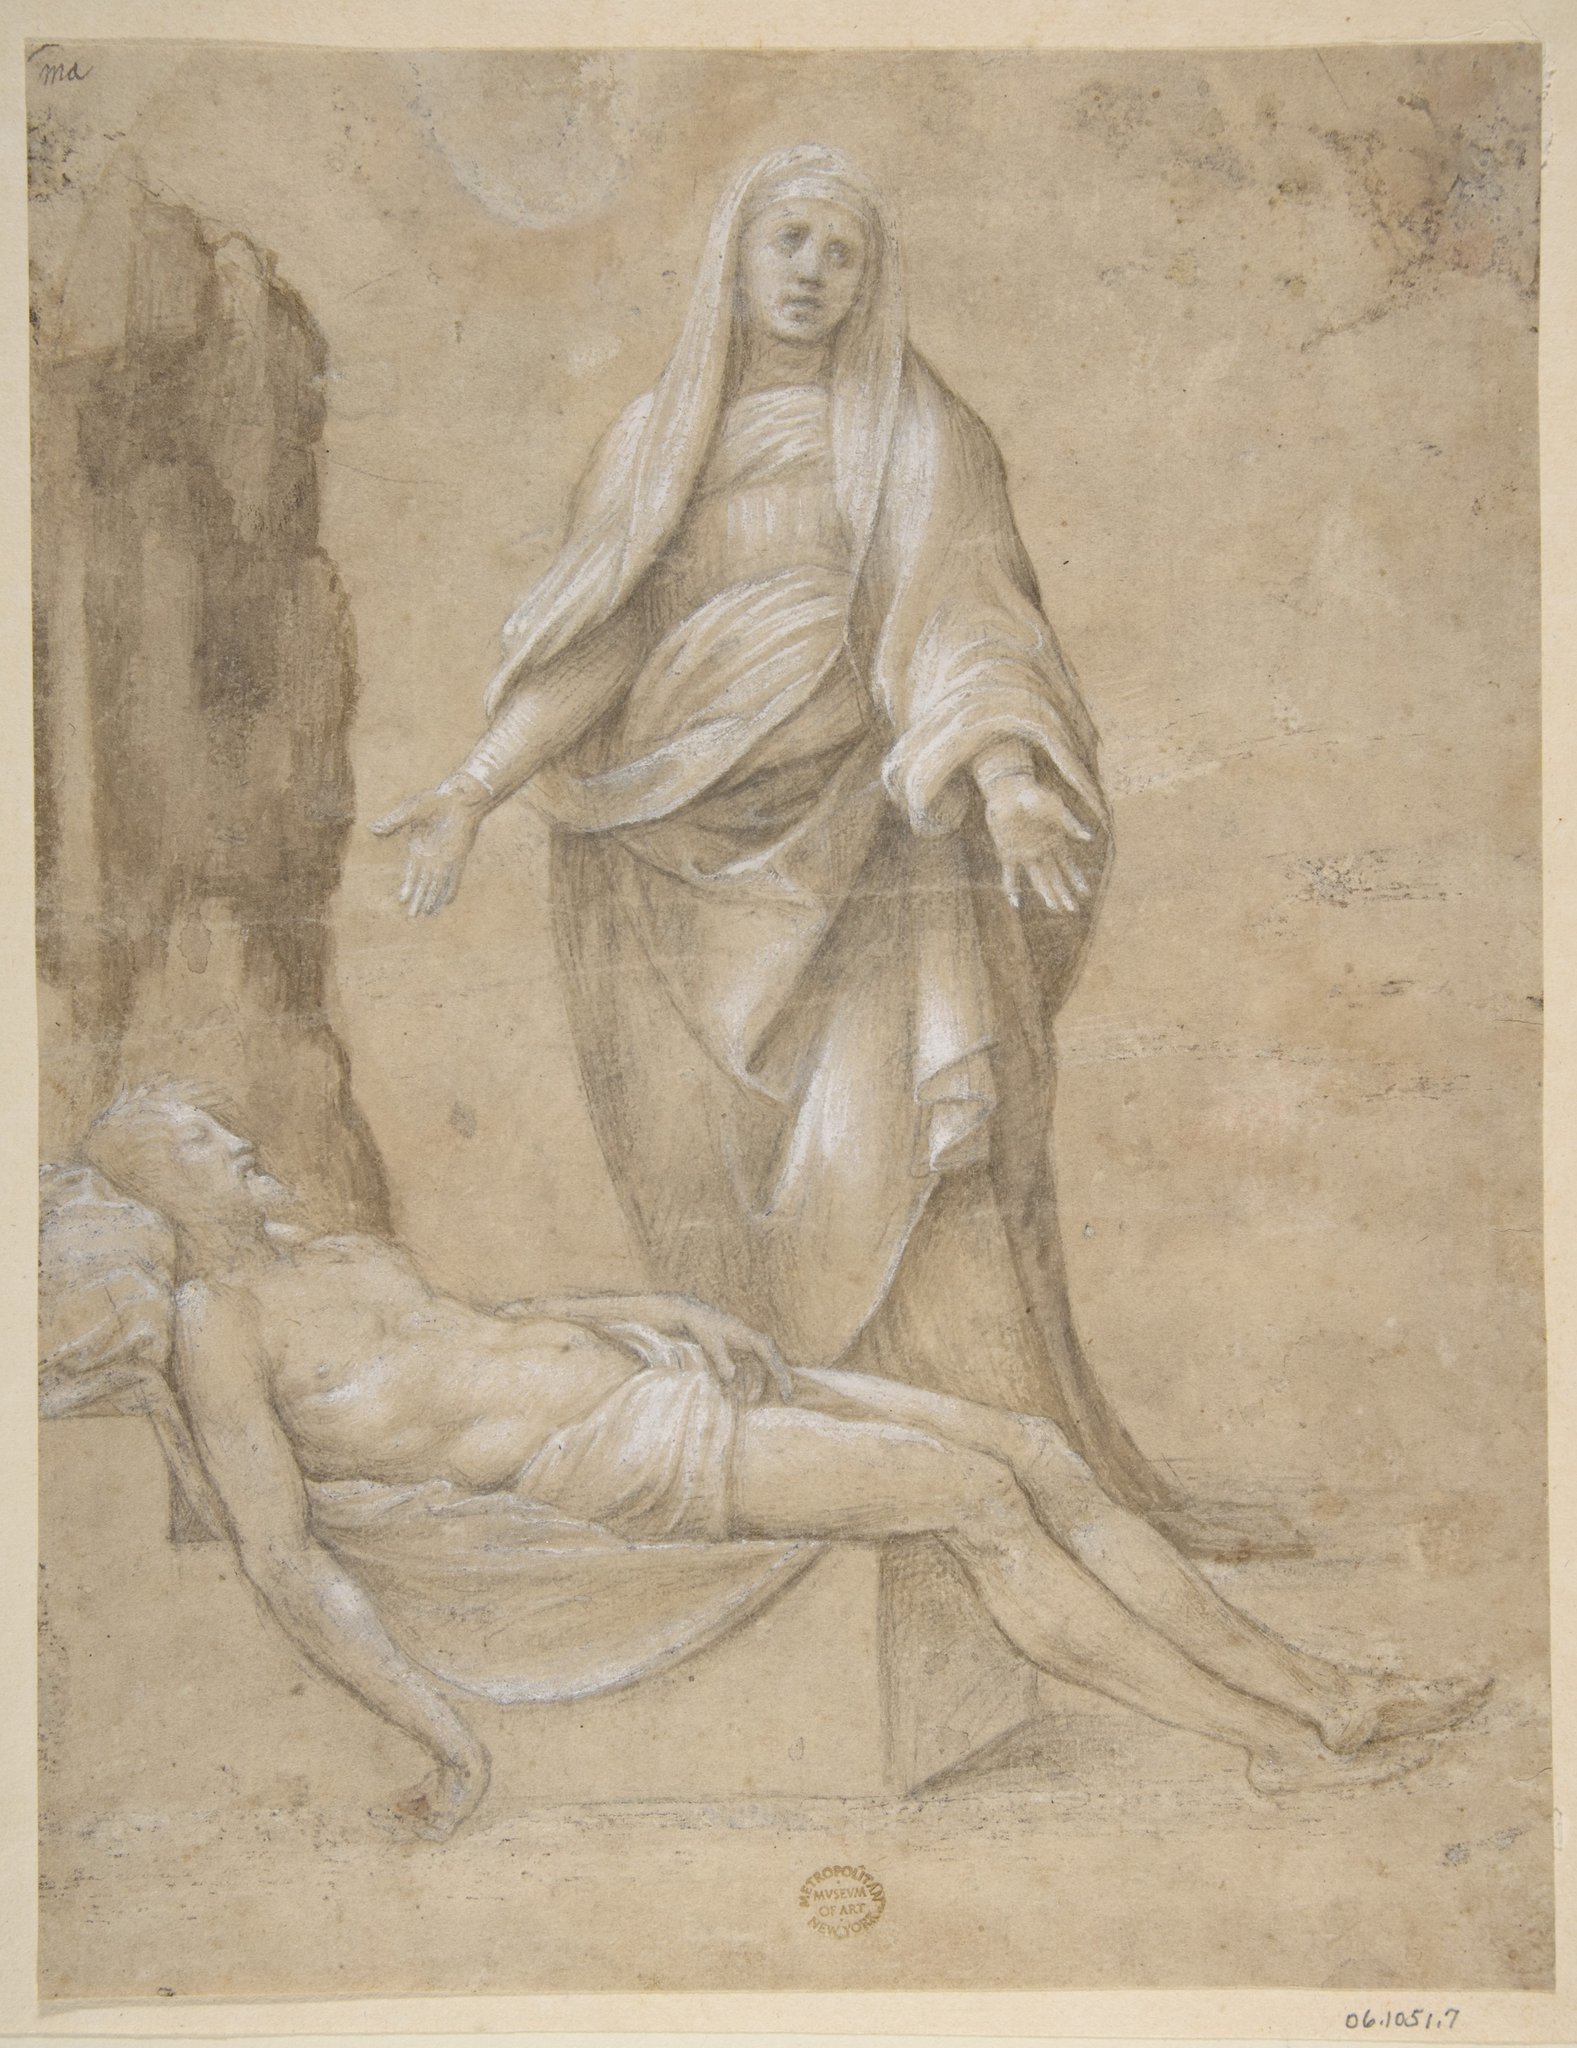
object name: drawing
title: Pietà (recto); Madonna and two cherubs (verso)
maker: raphael (raffaello sanzio or santi)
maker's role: artist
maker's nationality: italian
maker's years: 1483-1520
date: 1501-1600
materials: ink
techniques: brush, highlighting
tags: christ,madonna,death